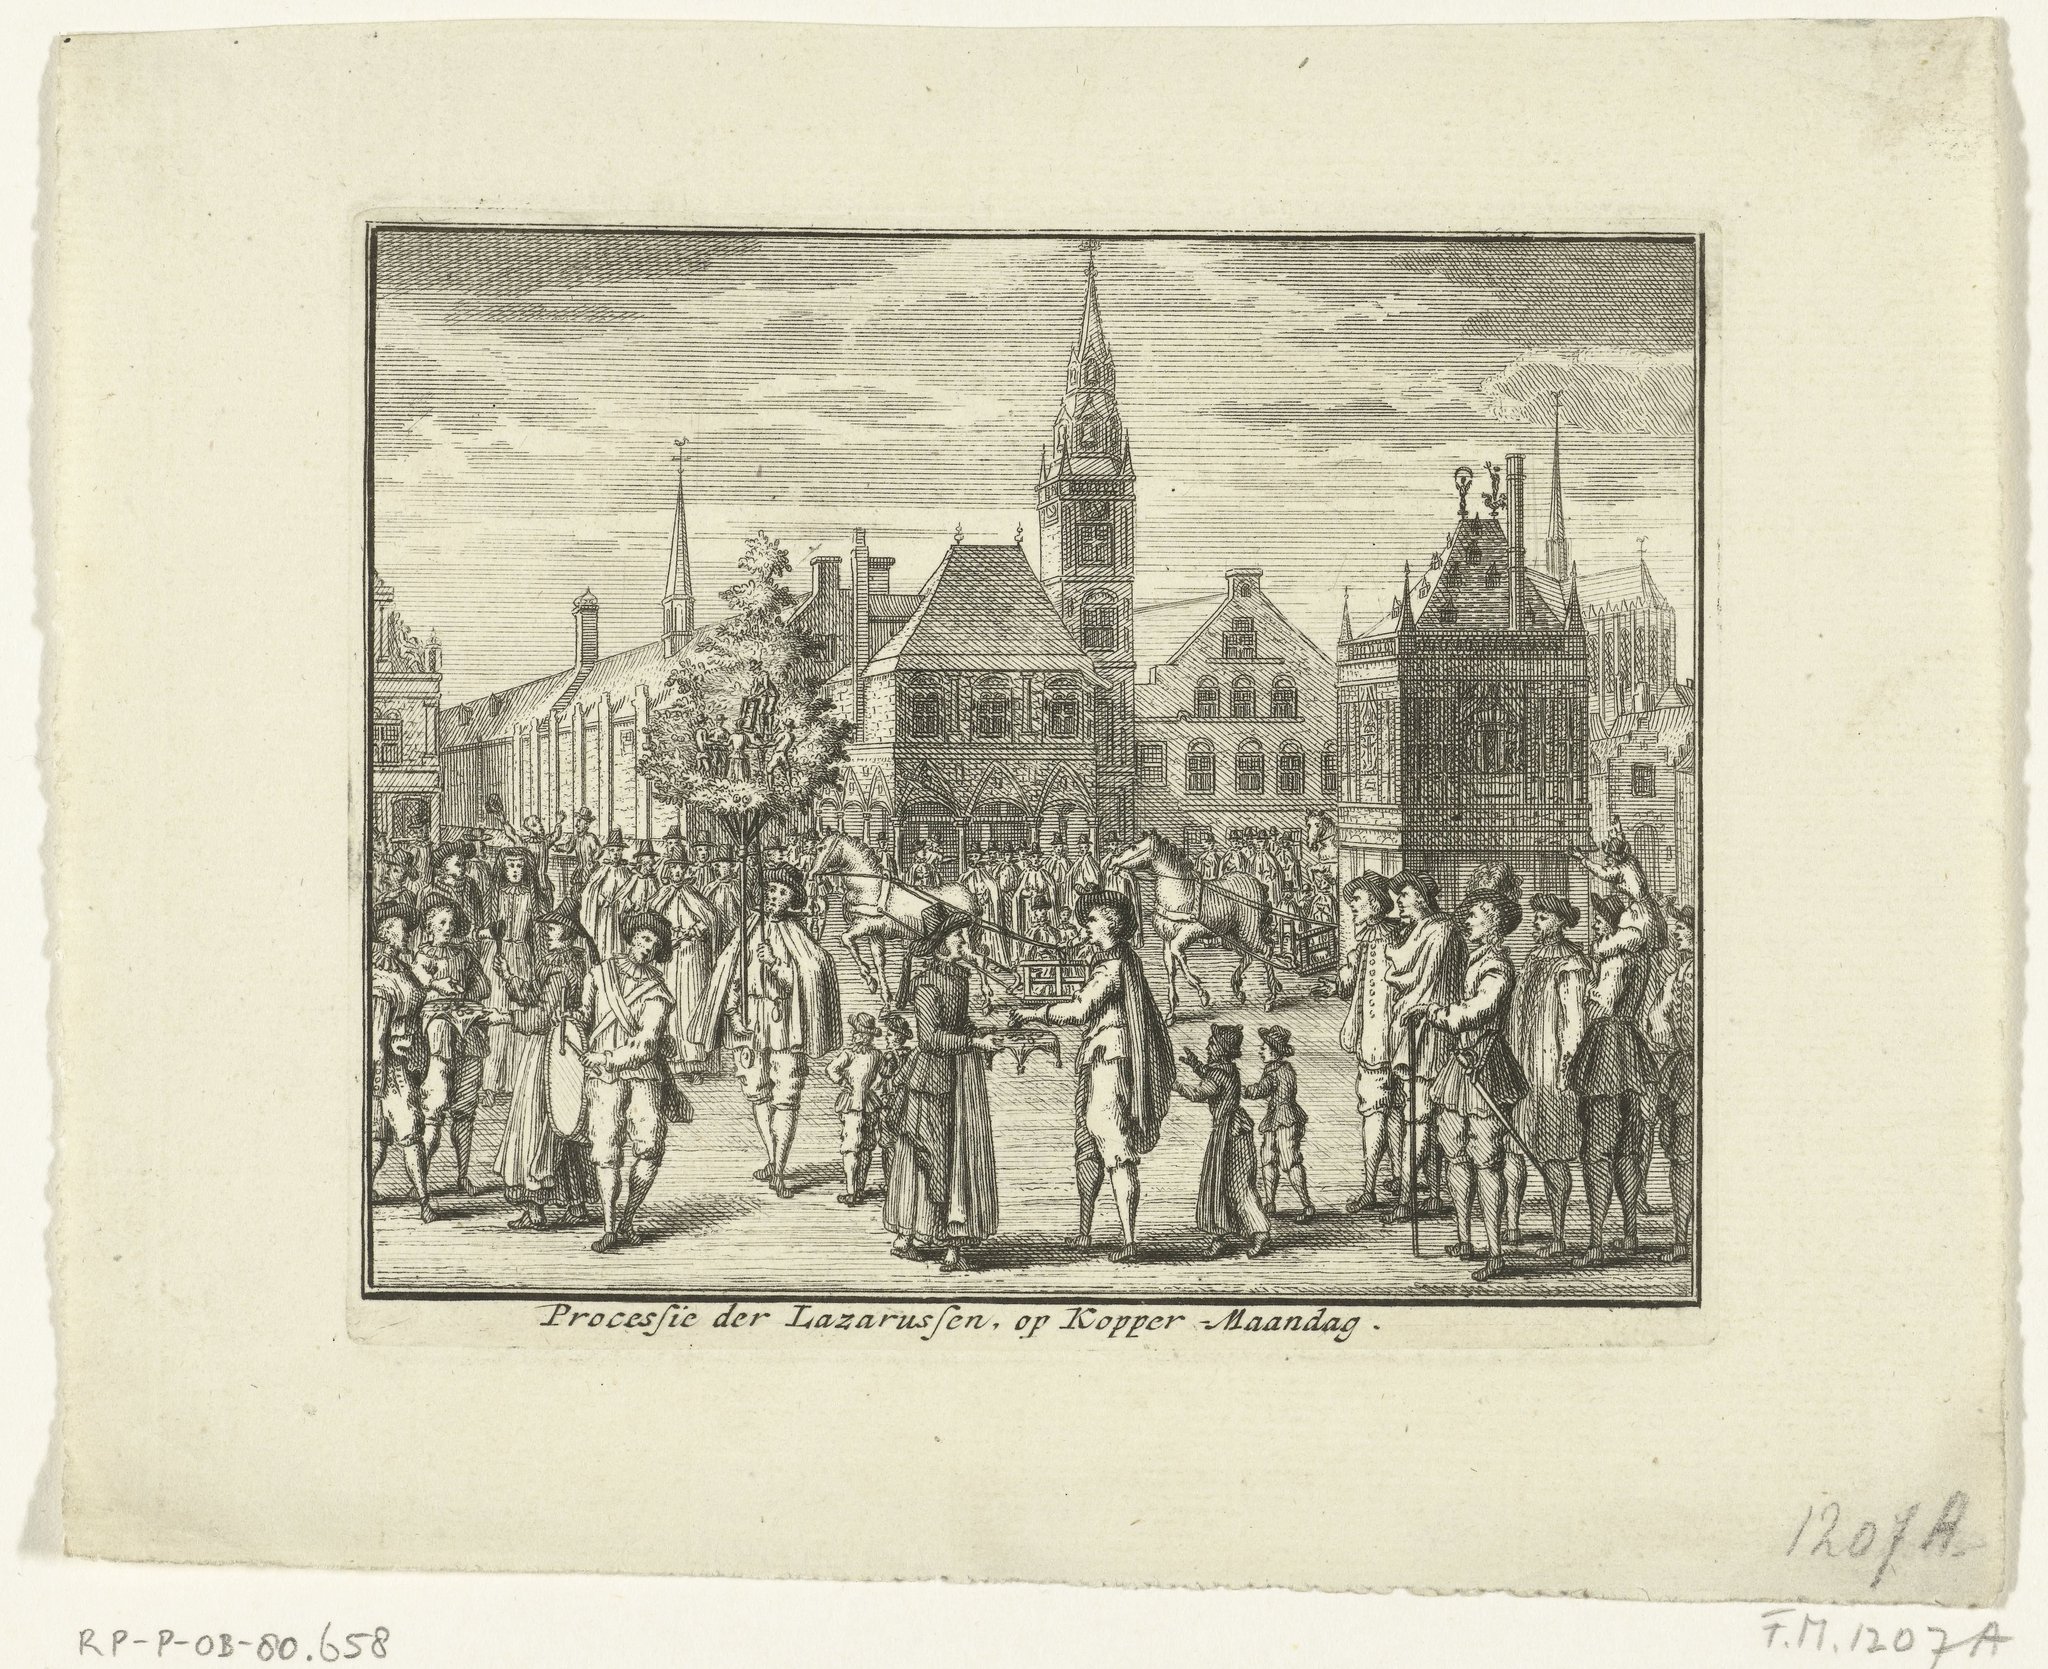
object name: history print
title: Processie der Lazarussen, op Kopper Maandag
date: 1729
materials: paper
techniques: engraving, etching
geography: amsterdam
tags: 'blue monday', leper's procession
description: De jaarlijkse optocht van de gilden op Koppermaandag (de eerste maandag na Driekoningen) te Amsterdam, 1604. Optocht en feestelijkheden van de gilden op de Dam waarbij de leprozen de stad in mogen en waarbij geld voor hen werd ingezameld. In 1604 werd Koppermaandag voor het laatst in Amsterdam gevierd.